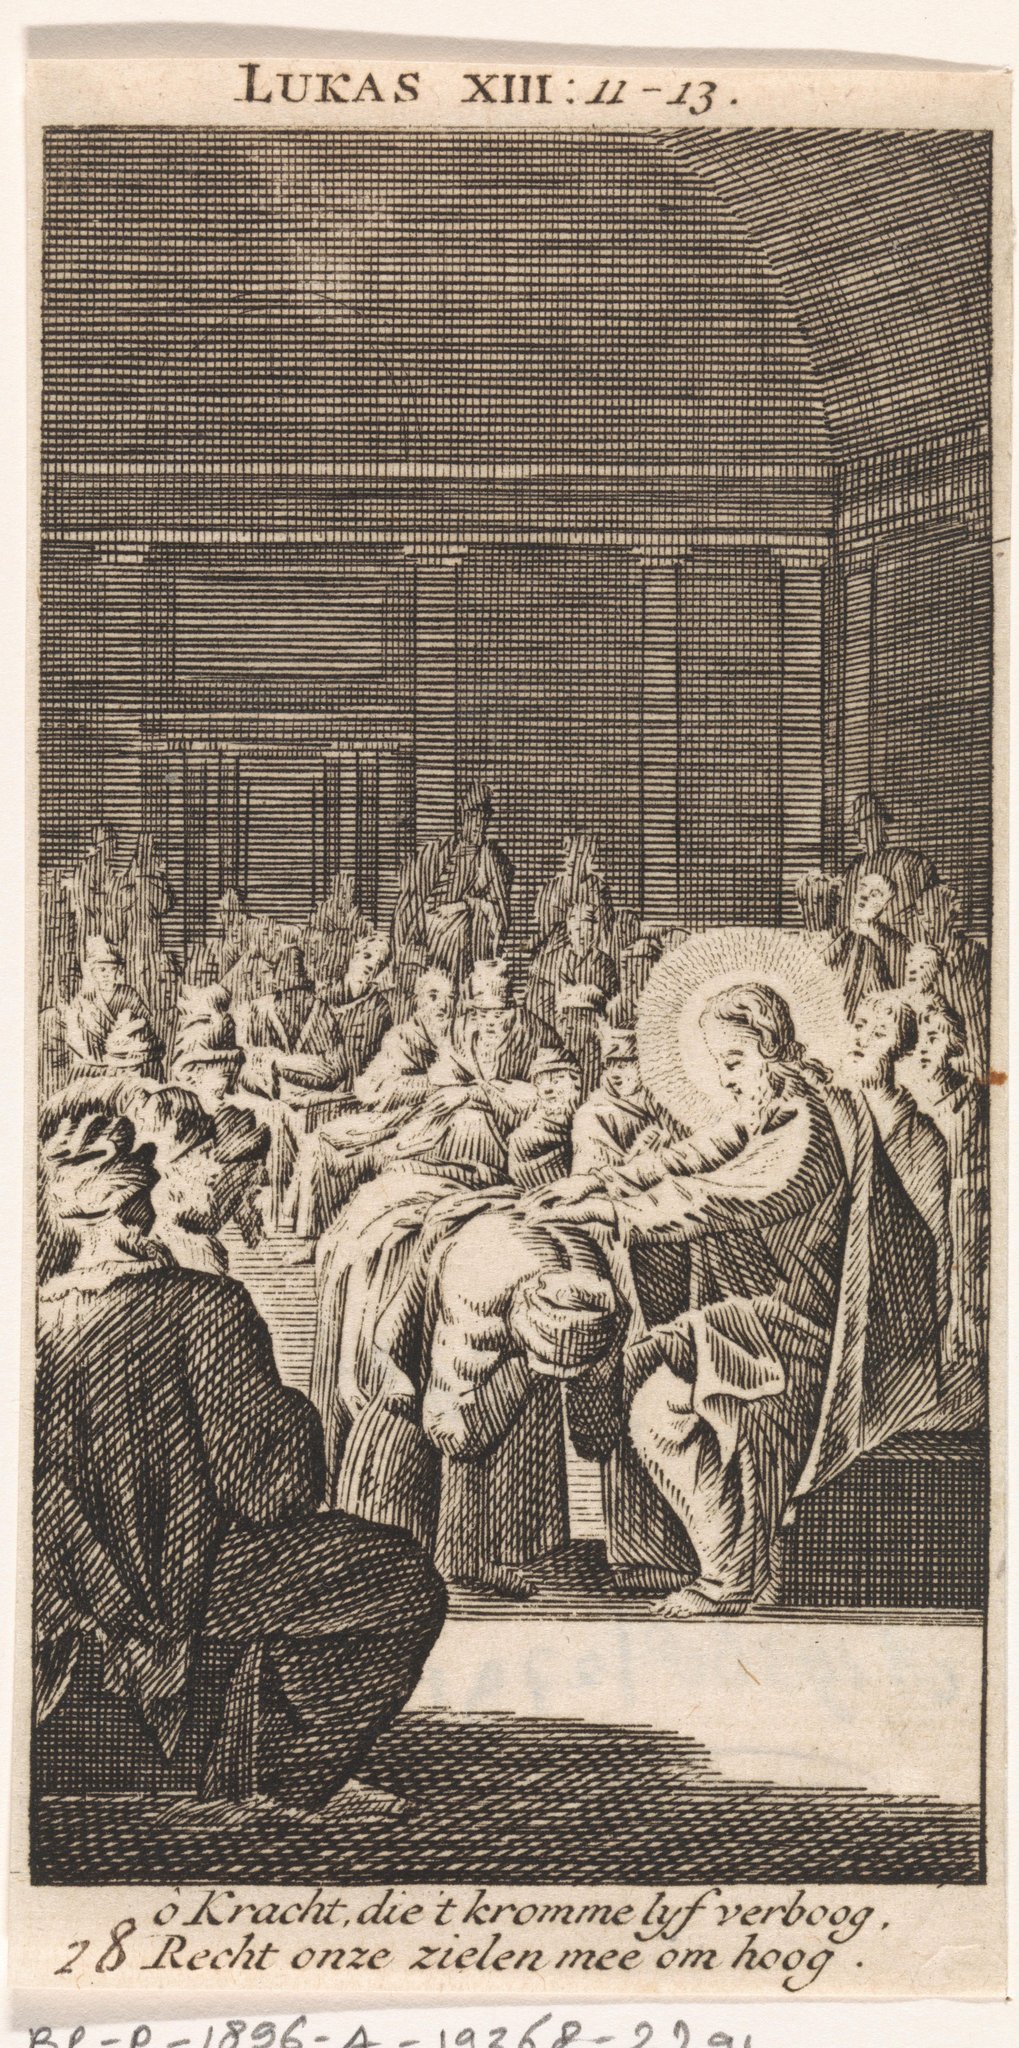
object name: print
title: Jezus legt de hand op een kromgebogen vrouw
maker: Anonymous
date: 1712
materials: paper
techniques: etching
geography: amsterdam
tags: healing of a woman 'bent over' (luke 13:10-17)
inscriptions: collector's mark: Lugt 2228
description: Kopie van illustratie voor: Luyken, Jan. Bybel printen. Amsterdam: Pieter Arentsz. II (wed.) en Cornelis van der Sys, 1712, p. 25.